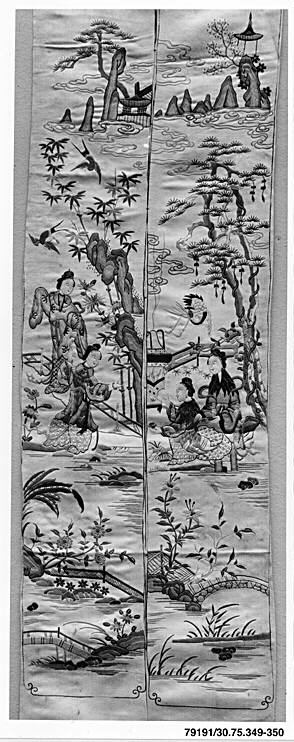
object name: sleeve band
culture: chinese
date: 1801-1900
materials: metal thread, silk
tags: women,landscapes